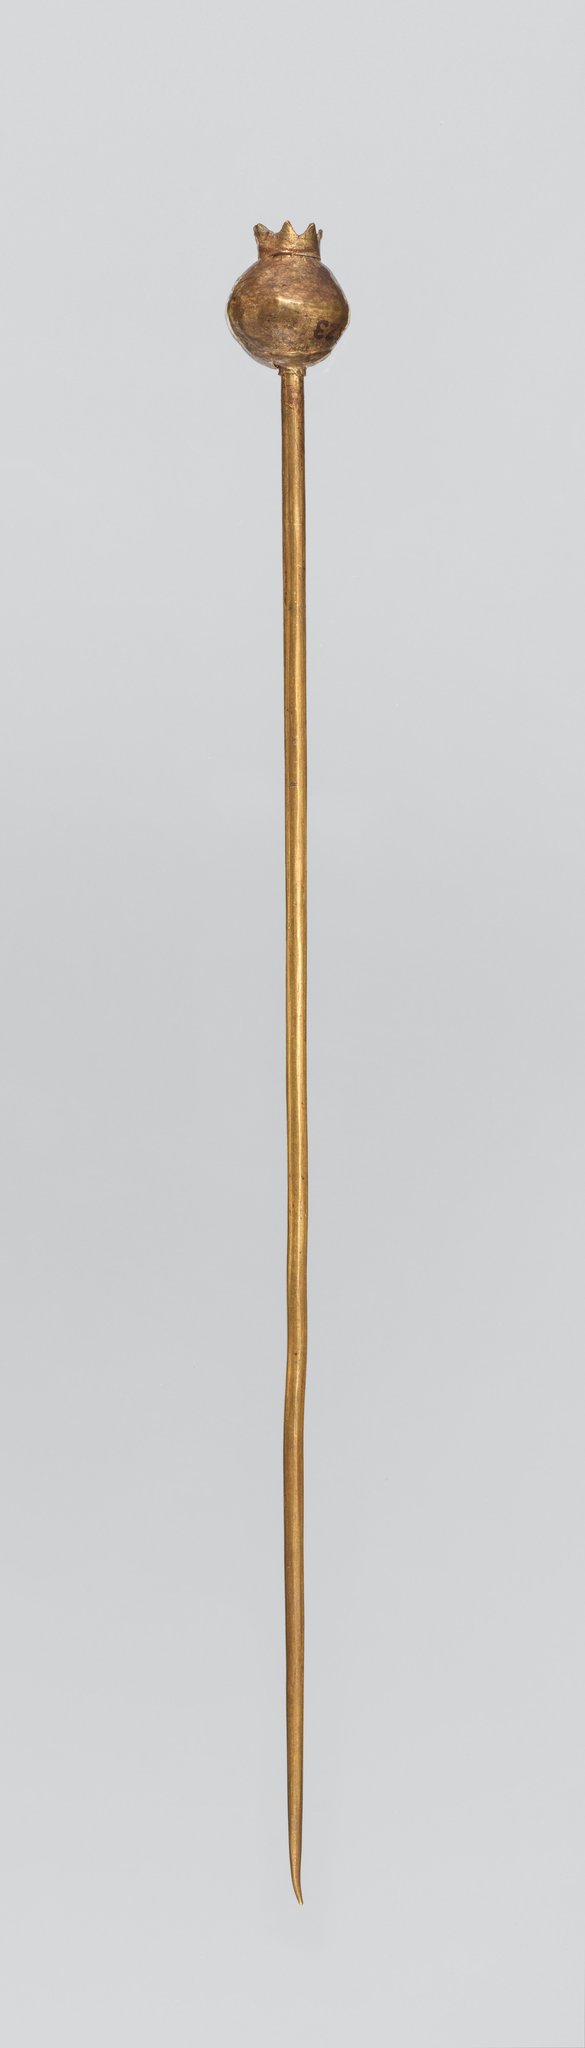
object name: pin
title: Gold pin with pomegranate head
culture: greek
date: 700-501 BCE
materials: gold, silver